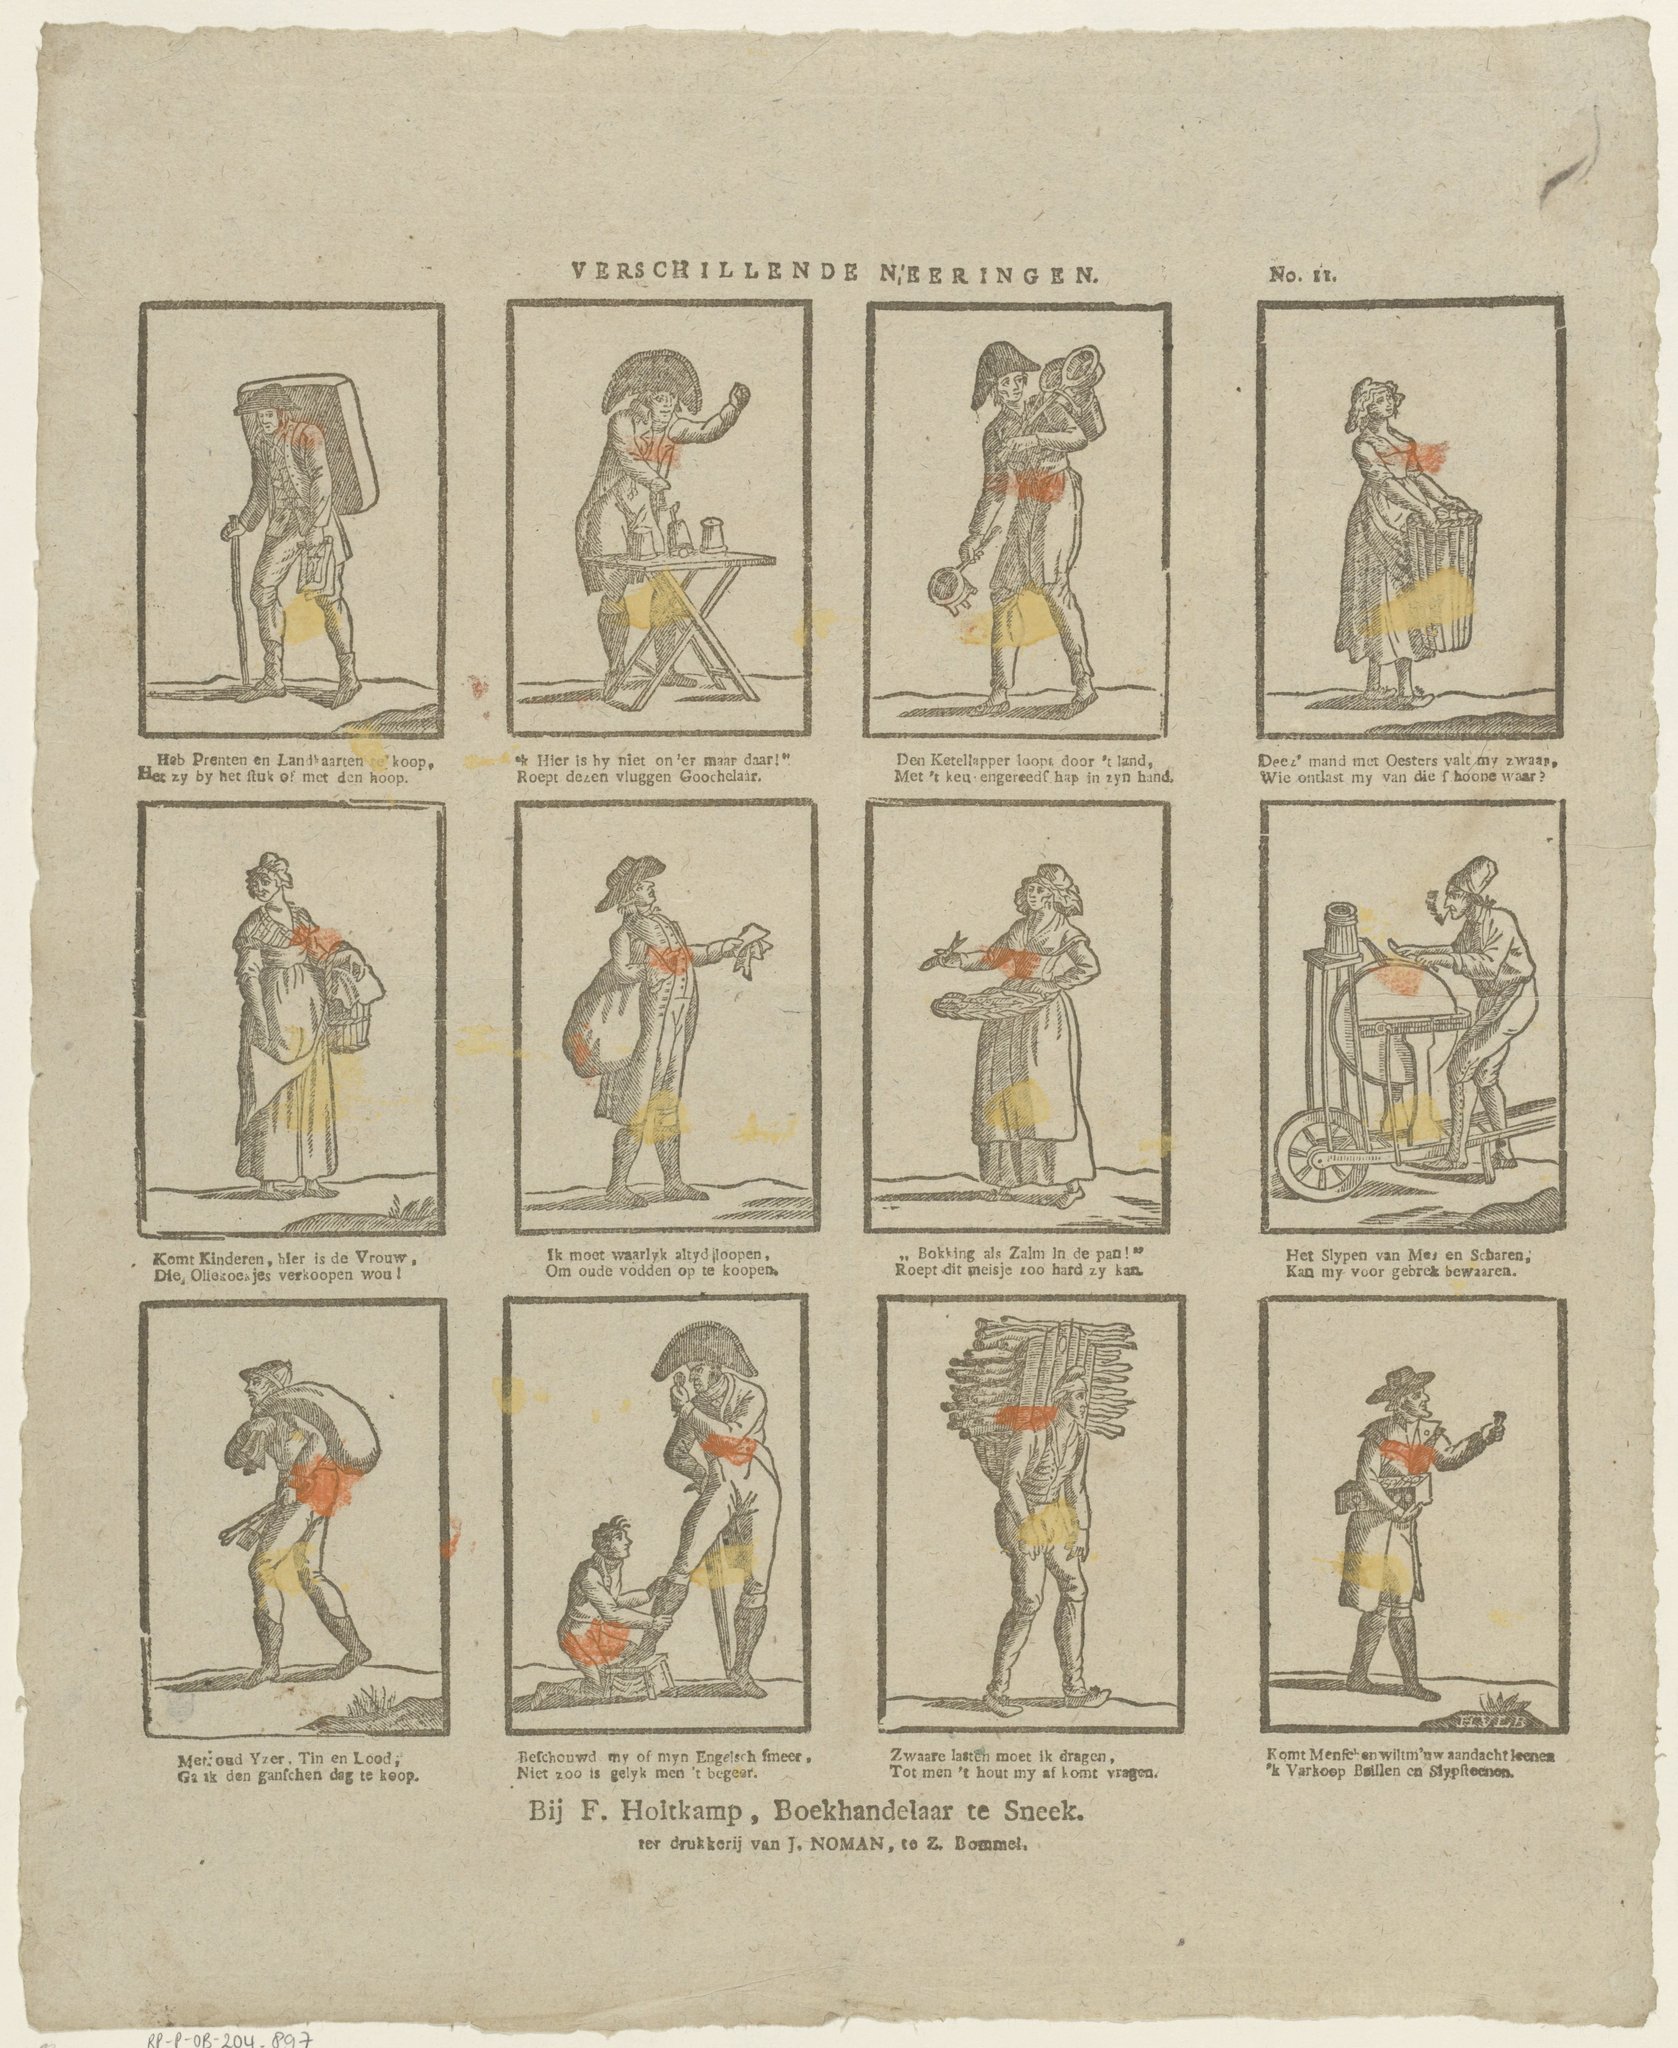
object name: popular print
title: Verschillende neeringen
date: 1806-1830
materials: paper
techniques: colour, letterpress printing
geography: sneek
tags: illusionist, conjurer, juggler, 'legerdemain', street-trader, merchant, salesman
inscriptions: collector's mark: Lugt 2760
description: Blad met 12 voorstellingen van verschillende beroepen, zoals straatverkoper en ketellapper. Onder elke afbeelding een onderschrift. Genummerd rechtsboven: No. 11.